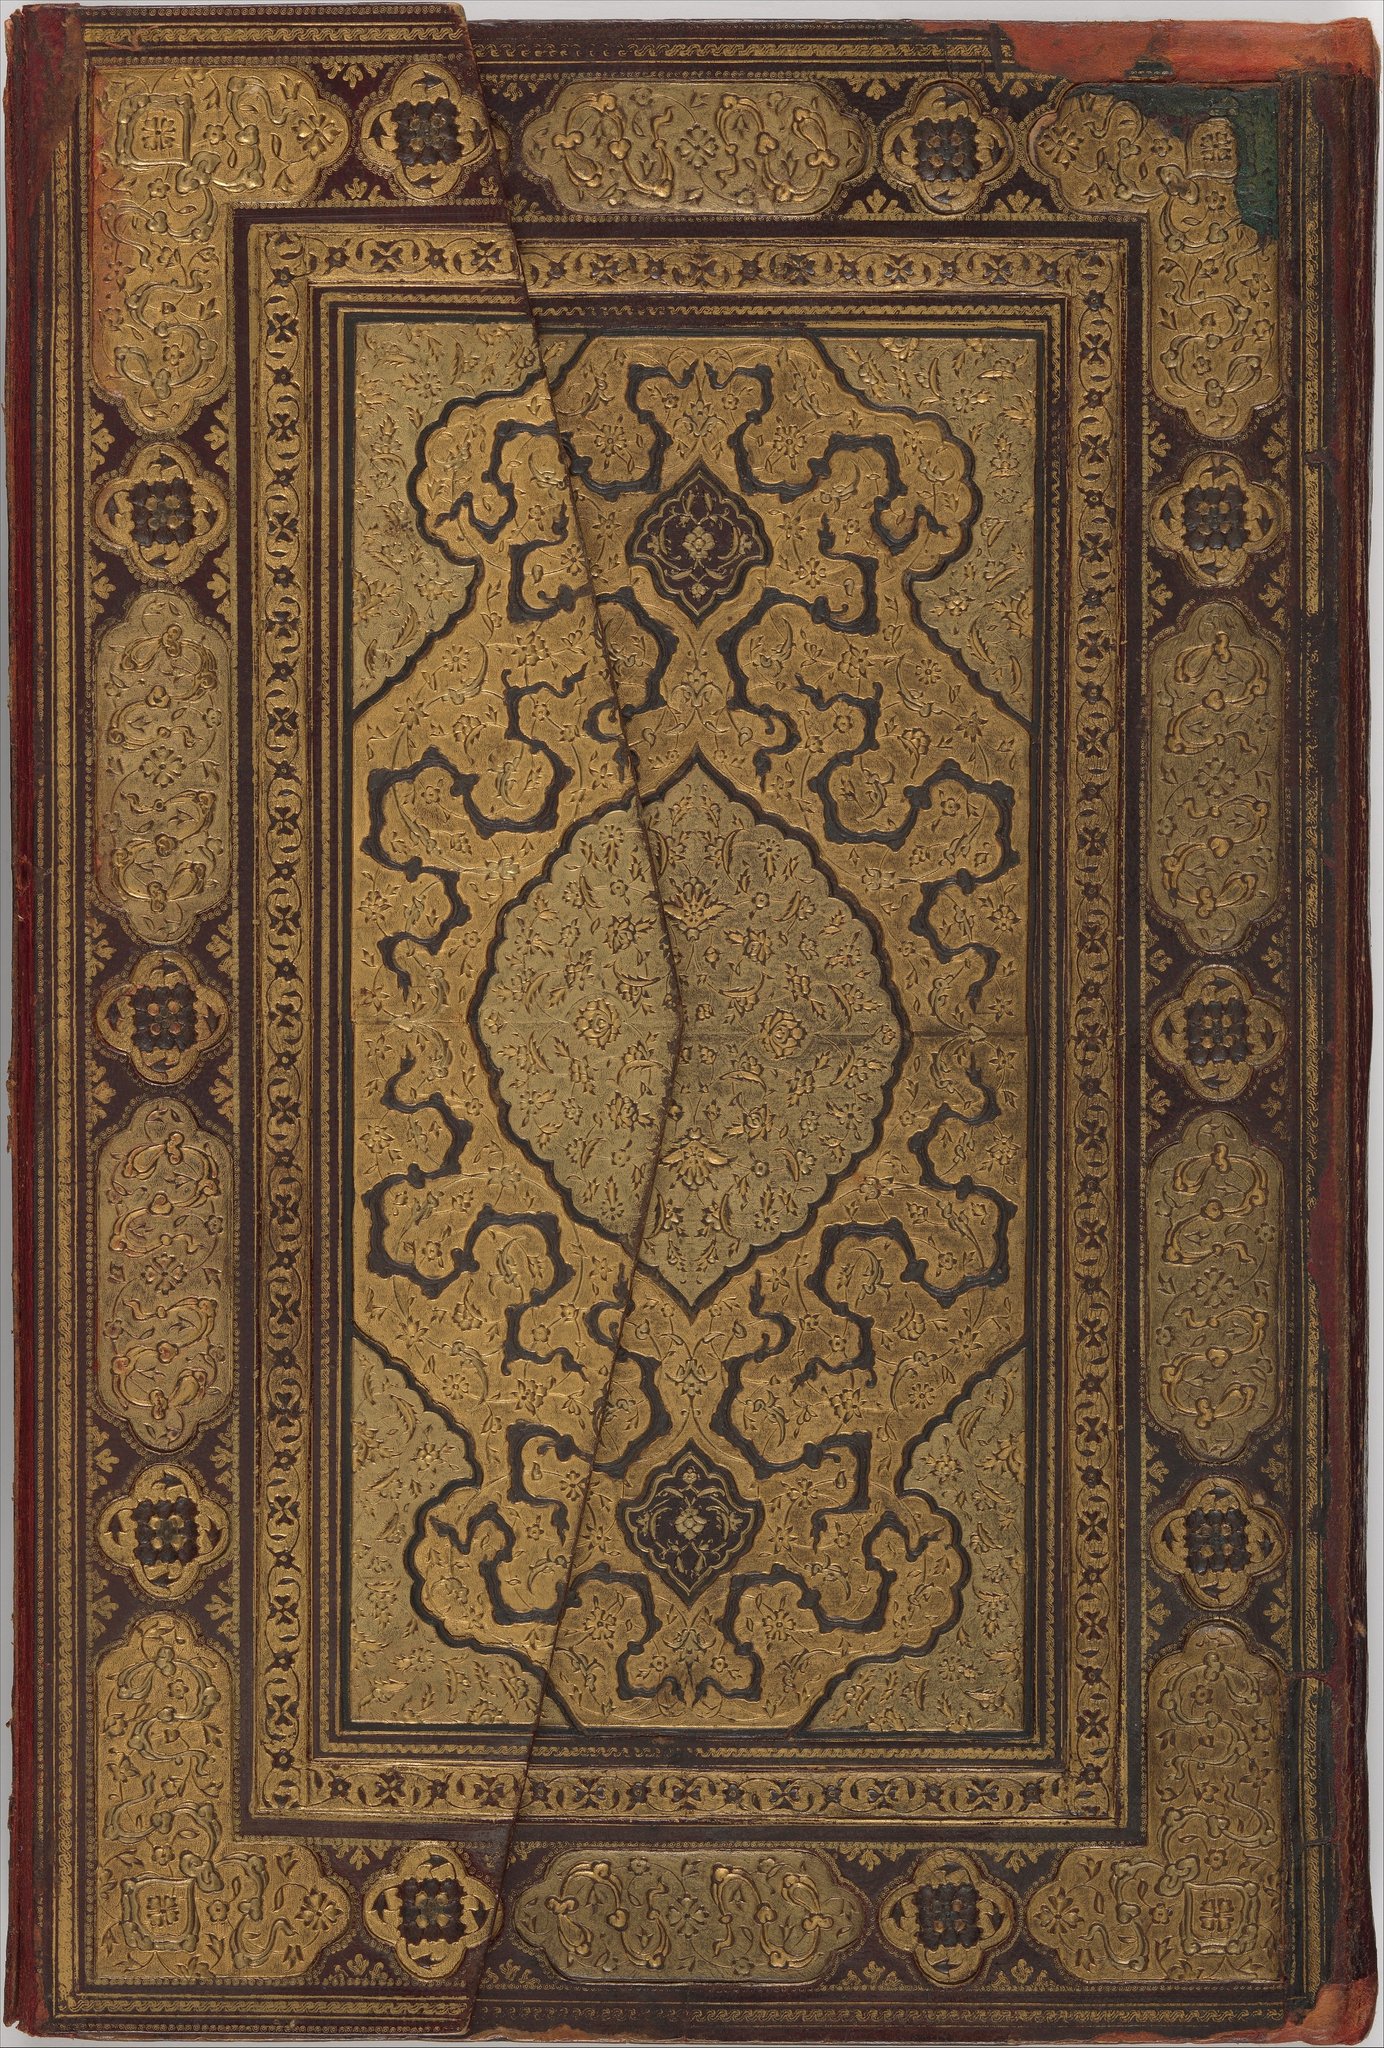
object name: bookbinding and text block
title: Binding and Text-Block for the Mantiq al-Tayr (Language of the Birds)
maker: farid al-din `attar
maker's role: author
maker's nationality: iranian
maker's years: 1142-1220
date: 1600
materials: gold, ink, leather, paper, silver, watercolor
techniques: bookbinding, carving, gilding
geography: iran